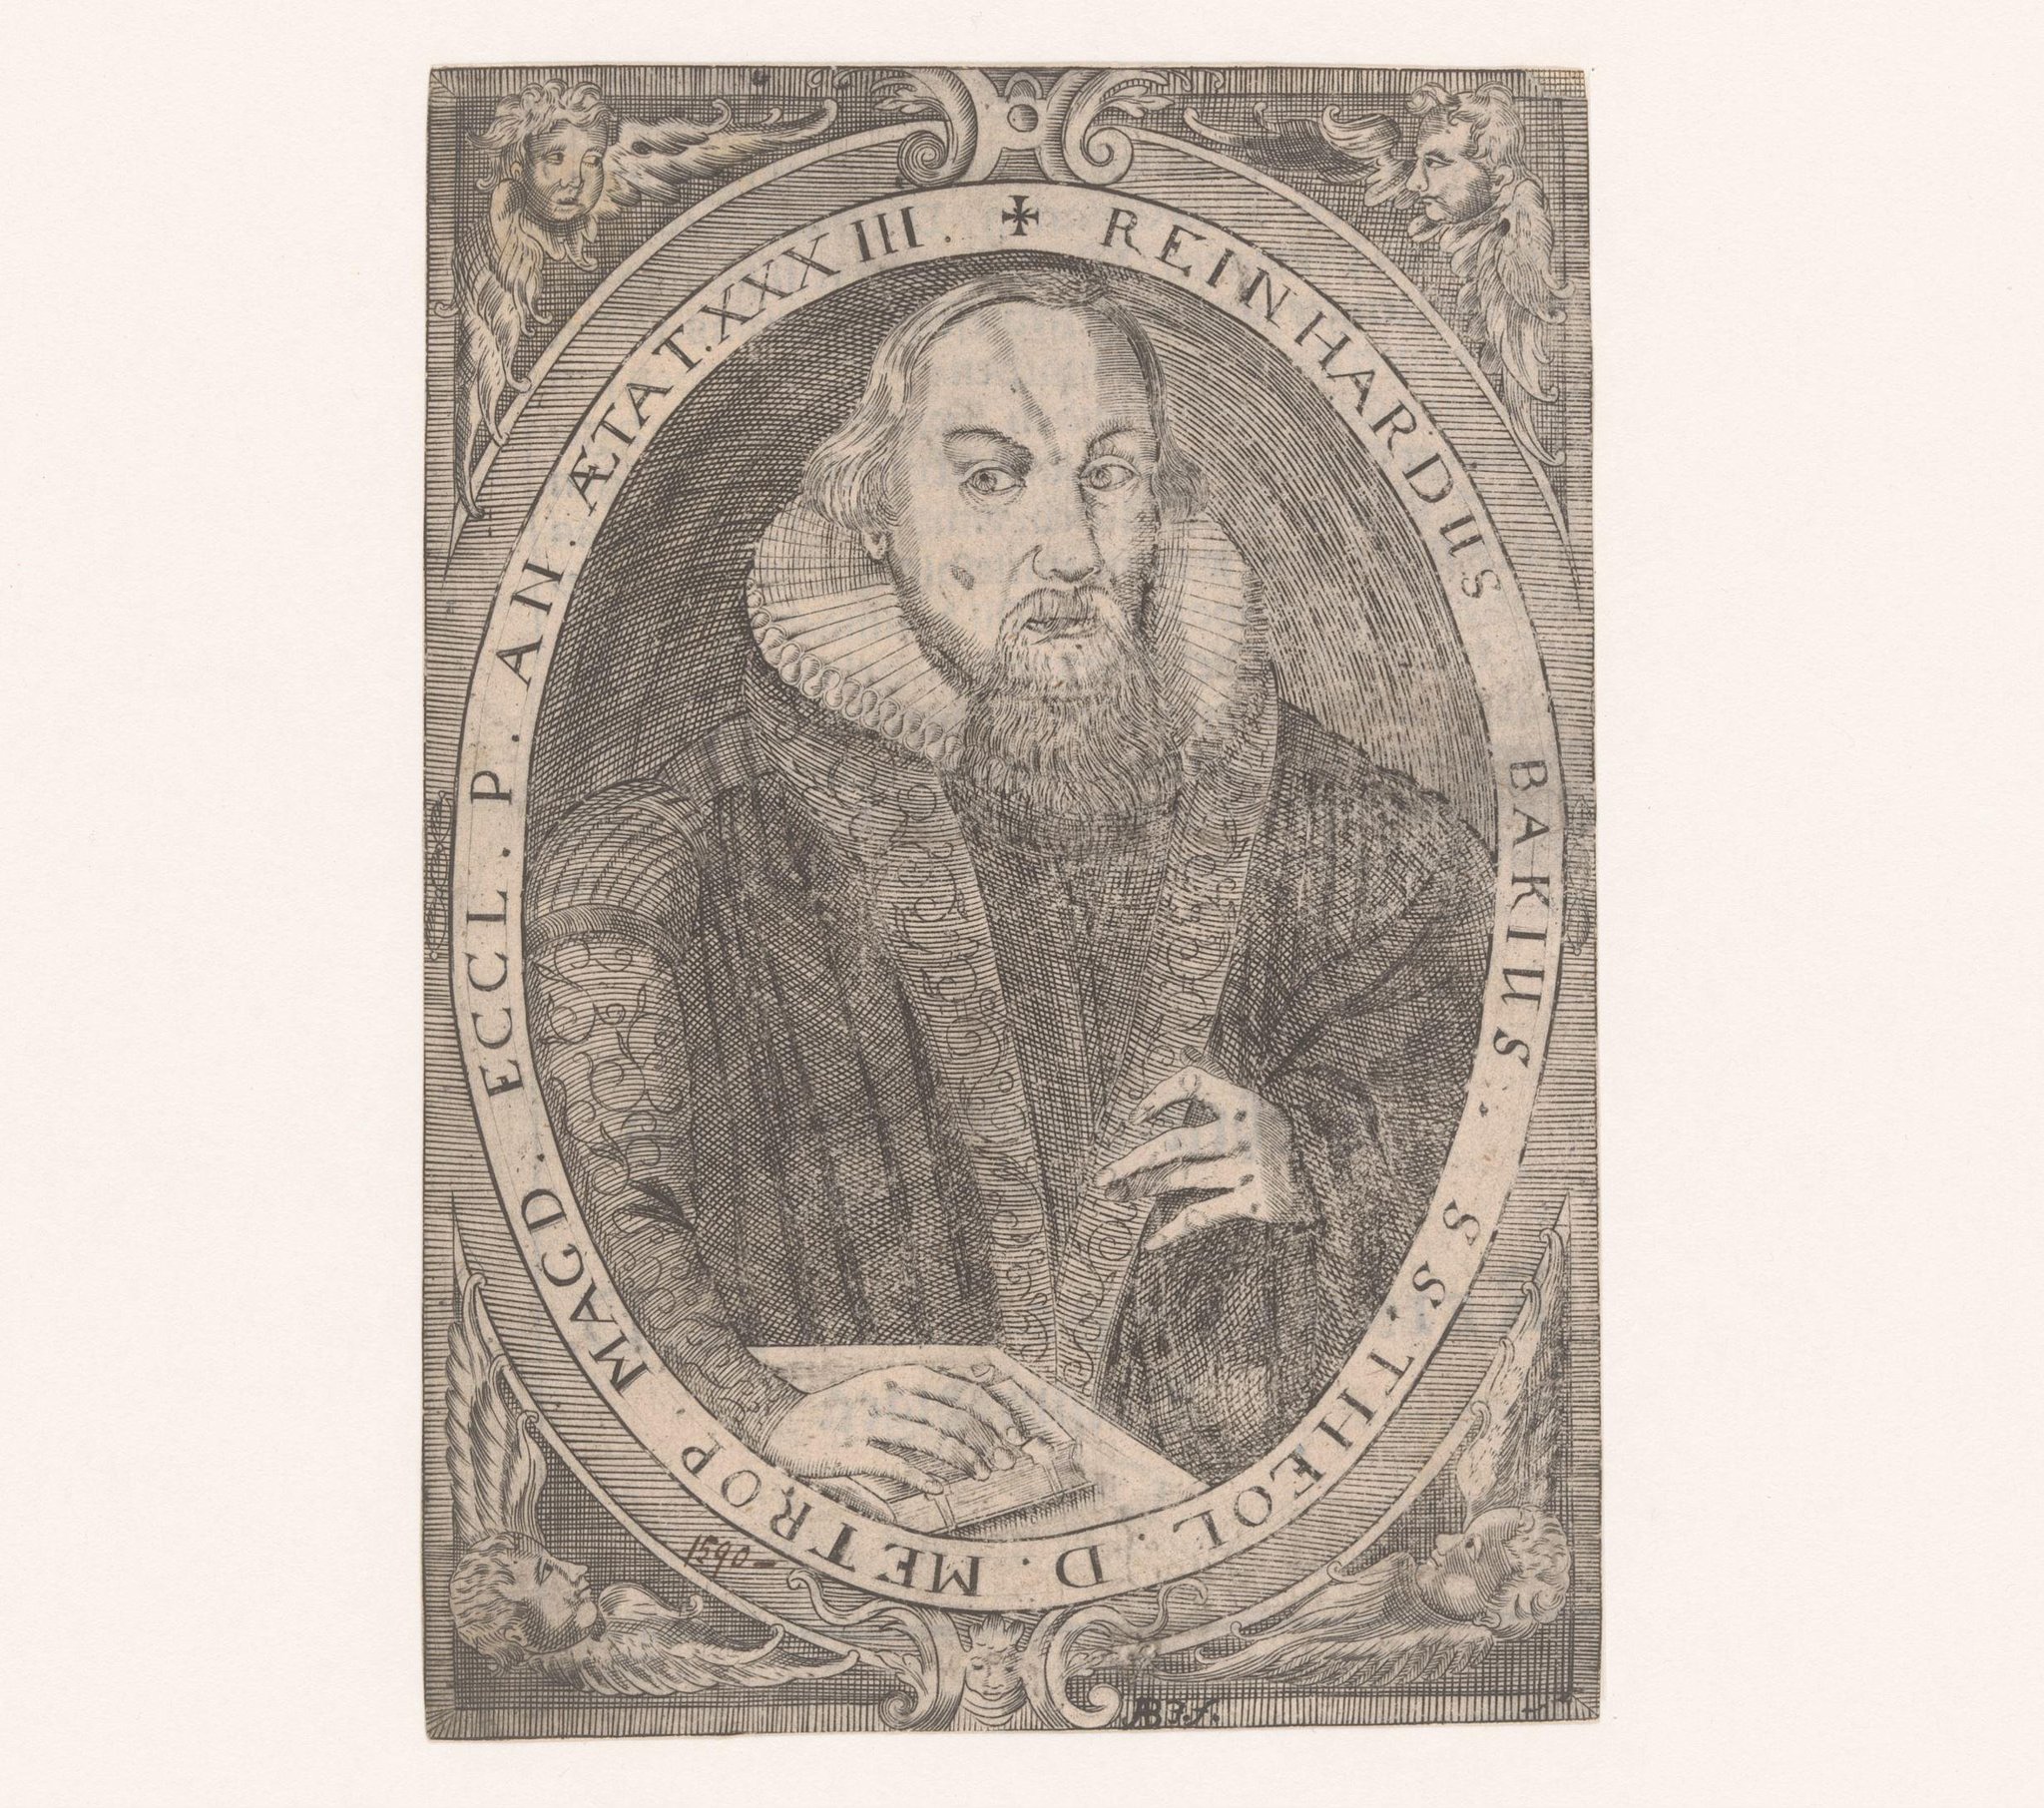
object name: print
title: Portret van Reinhard Bake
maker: monogrammist ab (17e eeuw)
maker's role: print maker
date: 1607-1657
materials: paper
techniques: engraving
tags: historical persons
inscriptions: collector's mark: Lugt 2228, date